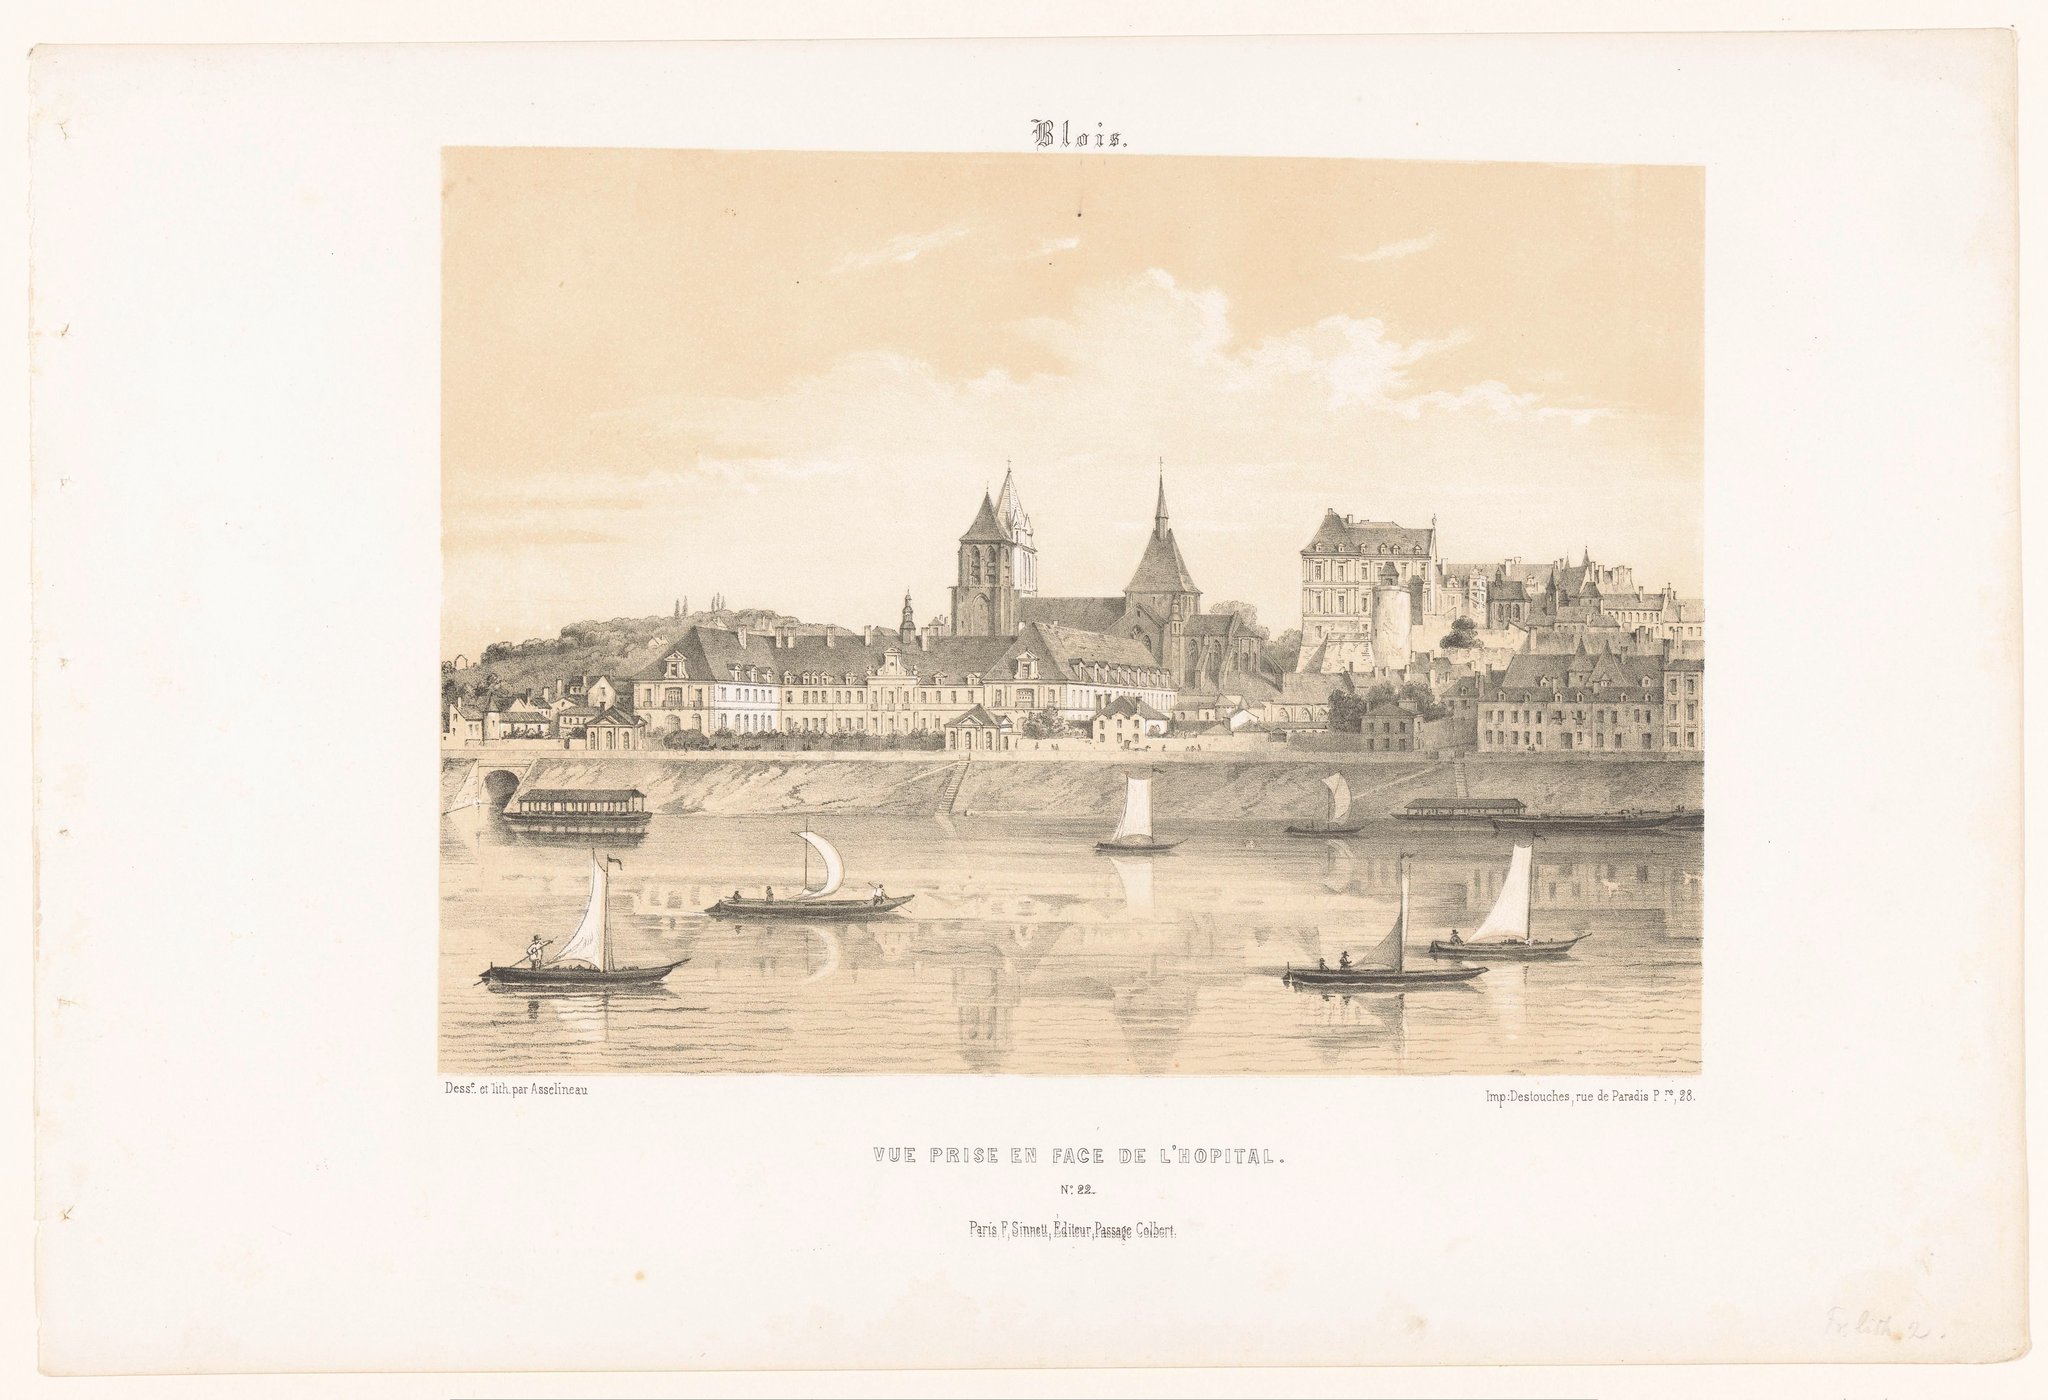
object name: print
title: Blois. Vue prise en face de l'Hopital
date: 1853-1856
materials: paper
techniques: tone lithography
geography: paris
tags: sailing-ship, sailing-boat, river, hospital, prospect of city, town panorama, silhouette of city (+ city(-scape) with figures, staffage)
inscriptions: collector's mark: Lugt 2228